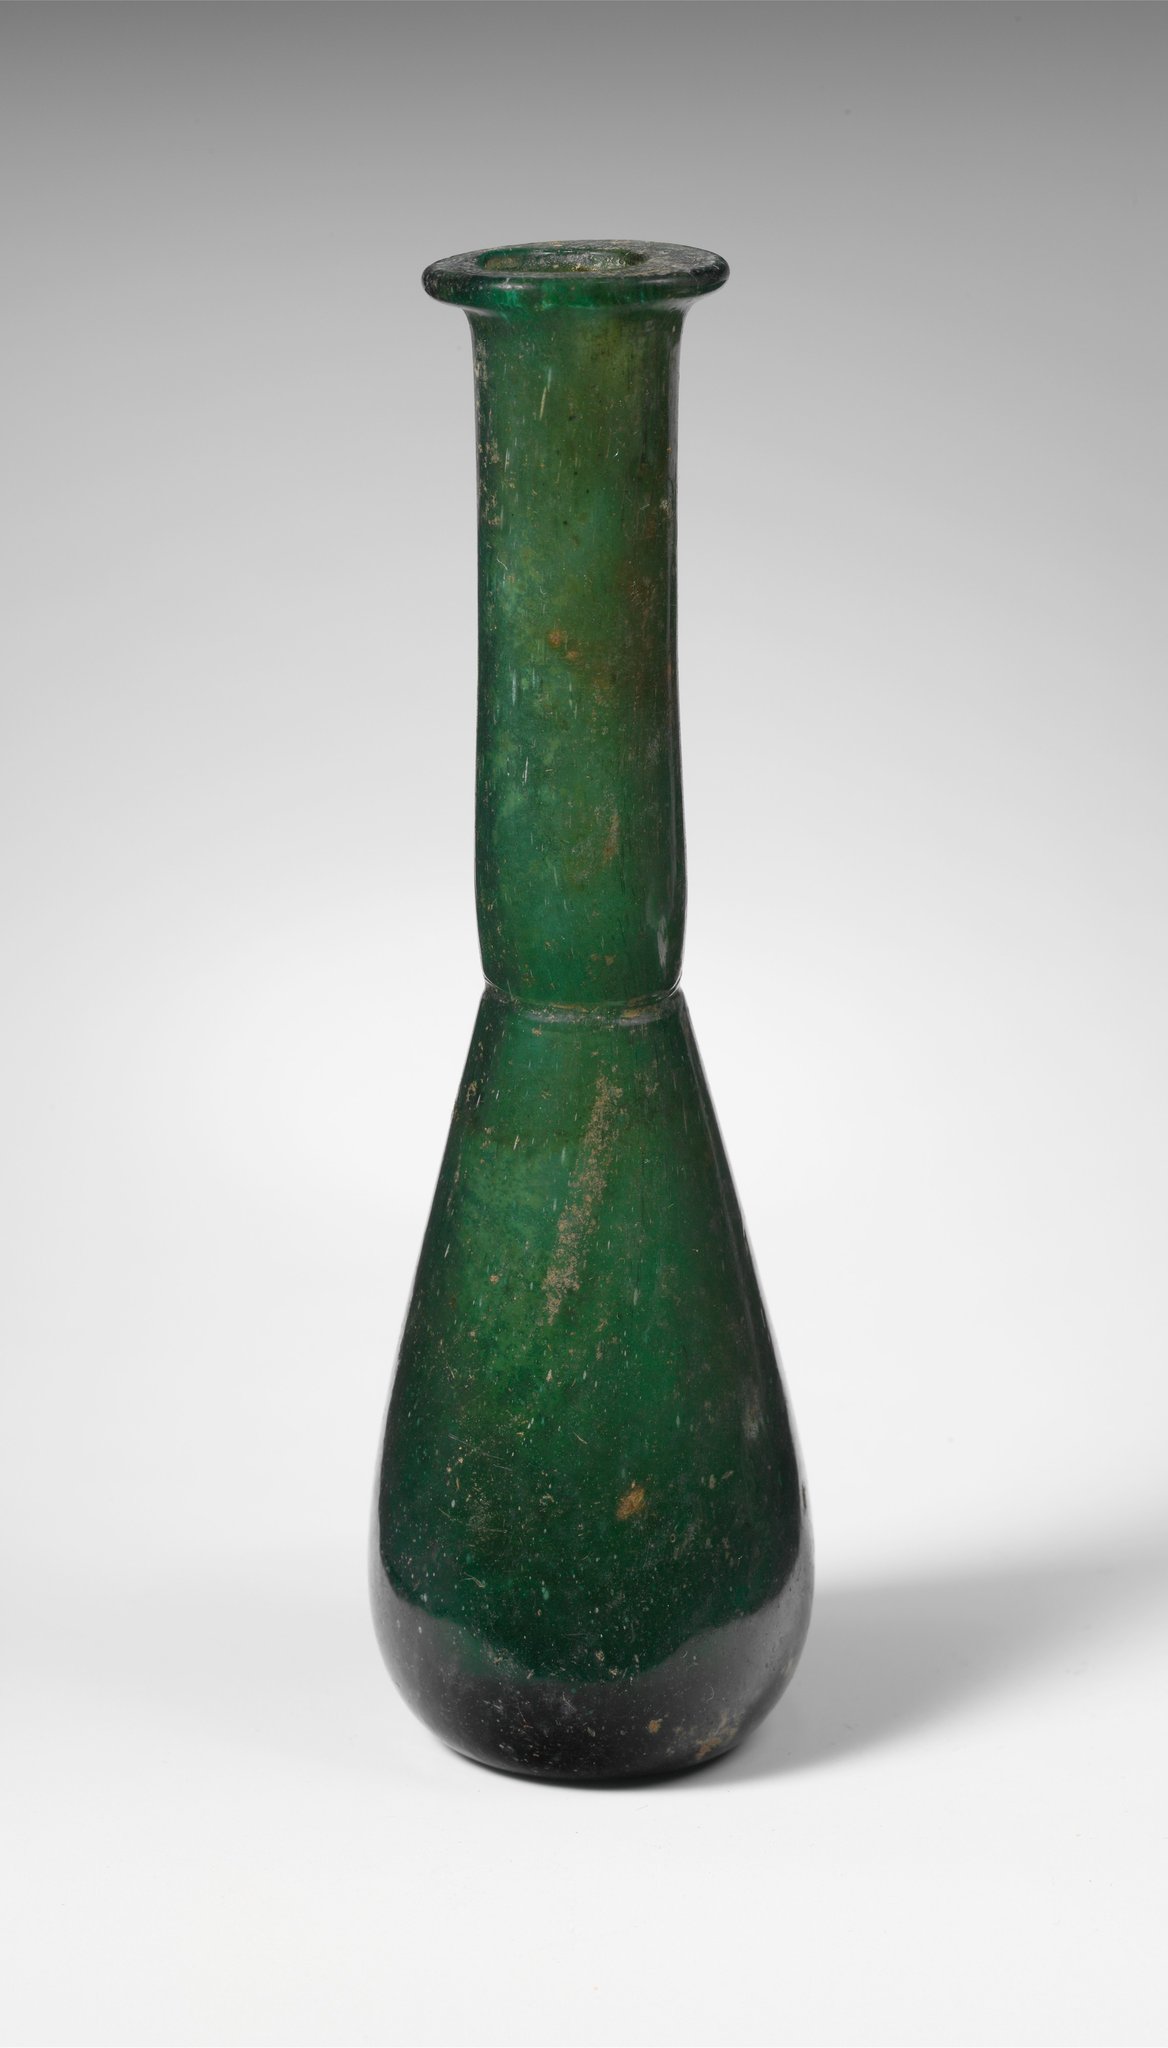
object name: perfume bottle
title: Glass perfume bottle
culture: roman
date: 1-200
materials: glass